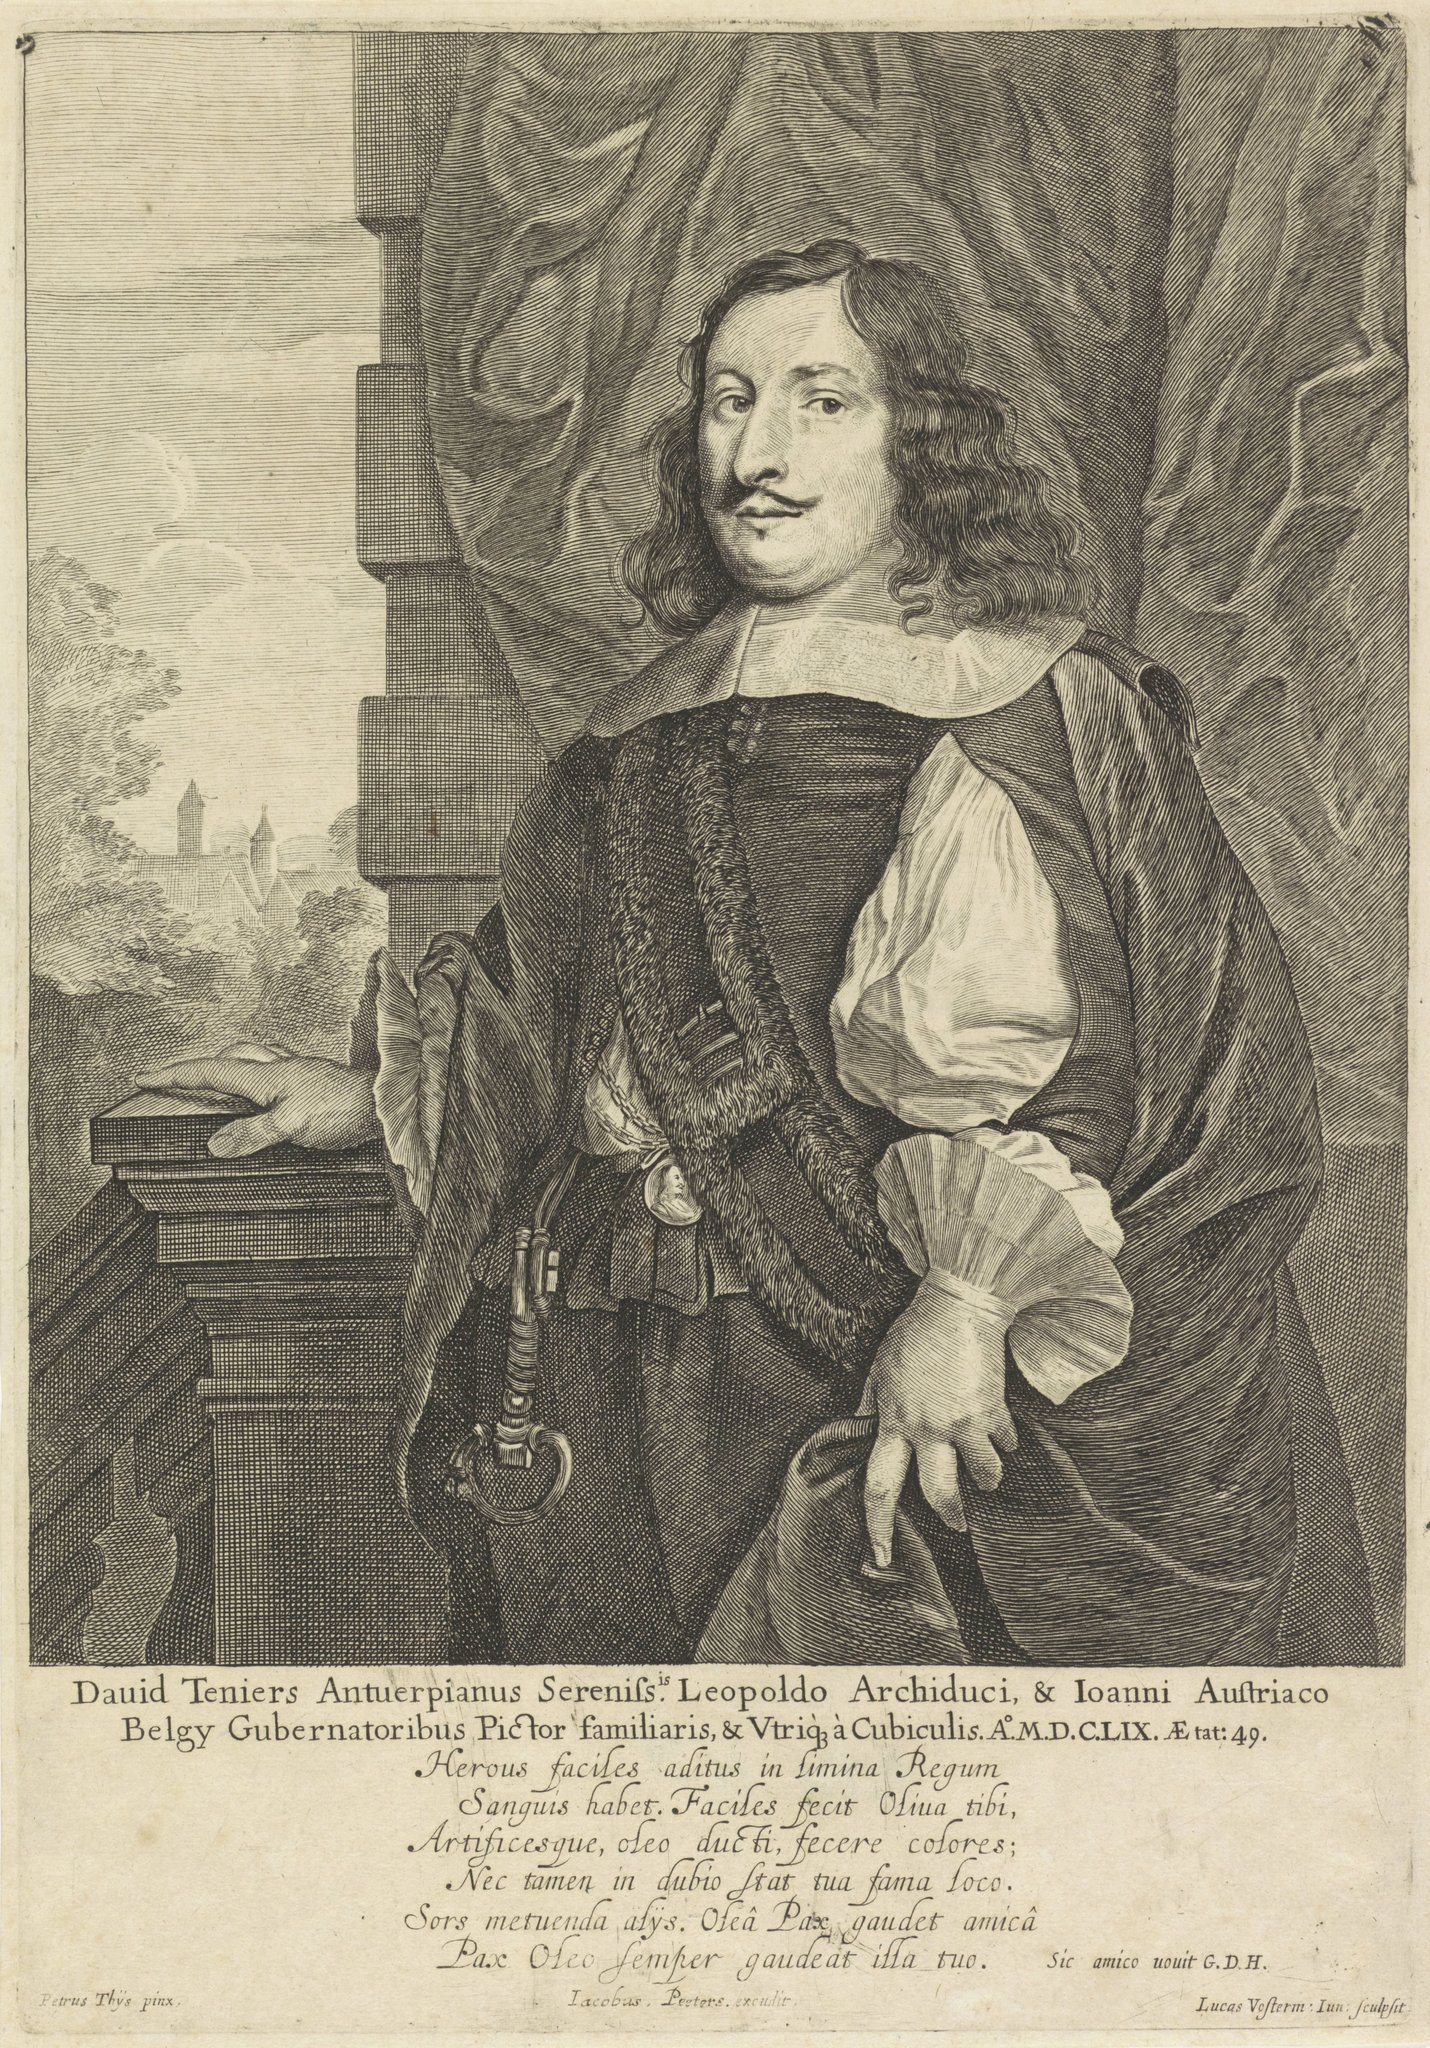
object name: print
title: Portret van Jan II Kazimierz, koning van Polen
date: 1633-1673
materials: paper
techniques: engraving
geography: antwerp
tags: knighthood order of the golden fleece, armorial bearing, heraldry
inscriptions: collector's mark: Lugt 2228, number: ‘22’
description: Portret van Jan II Kazimierz, koning van Polen. Hij draagt een keten met de Orde van het Gulden Vlies. In de marge zijn wapenschild en een tweeregelig onderschrift in het Latijn.